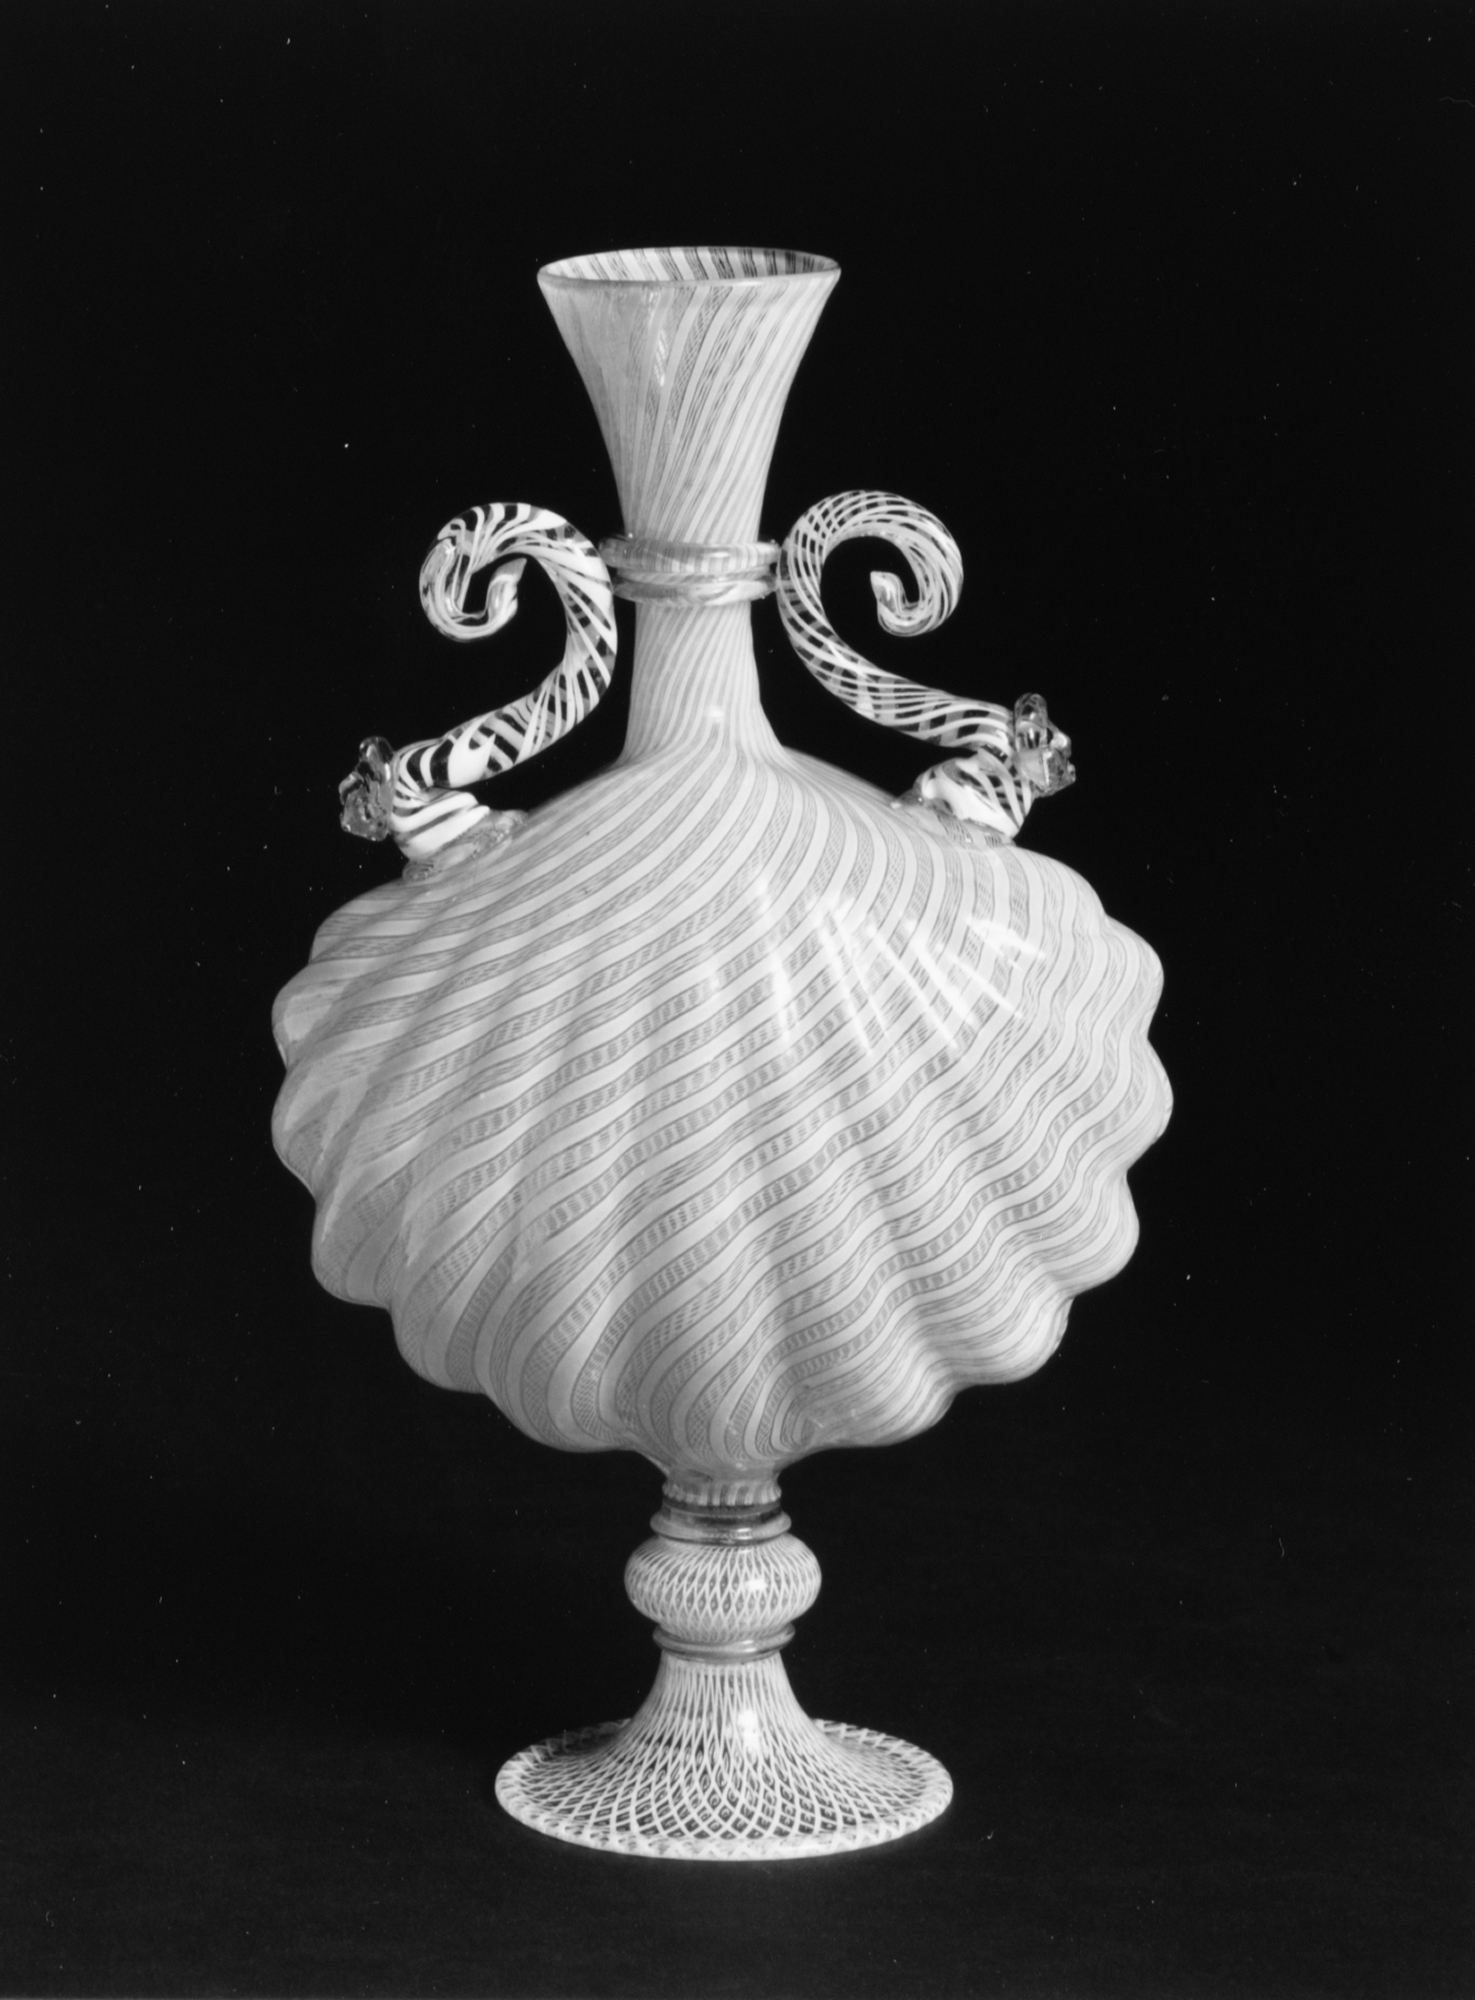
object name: vase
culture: italian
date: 1601-1633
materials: gilt, glass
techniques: glassblowing, molding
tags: shells